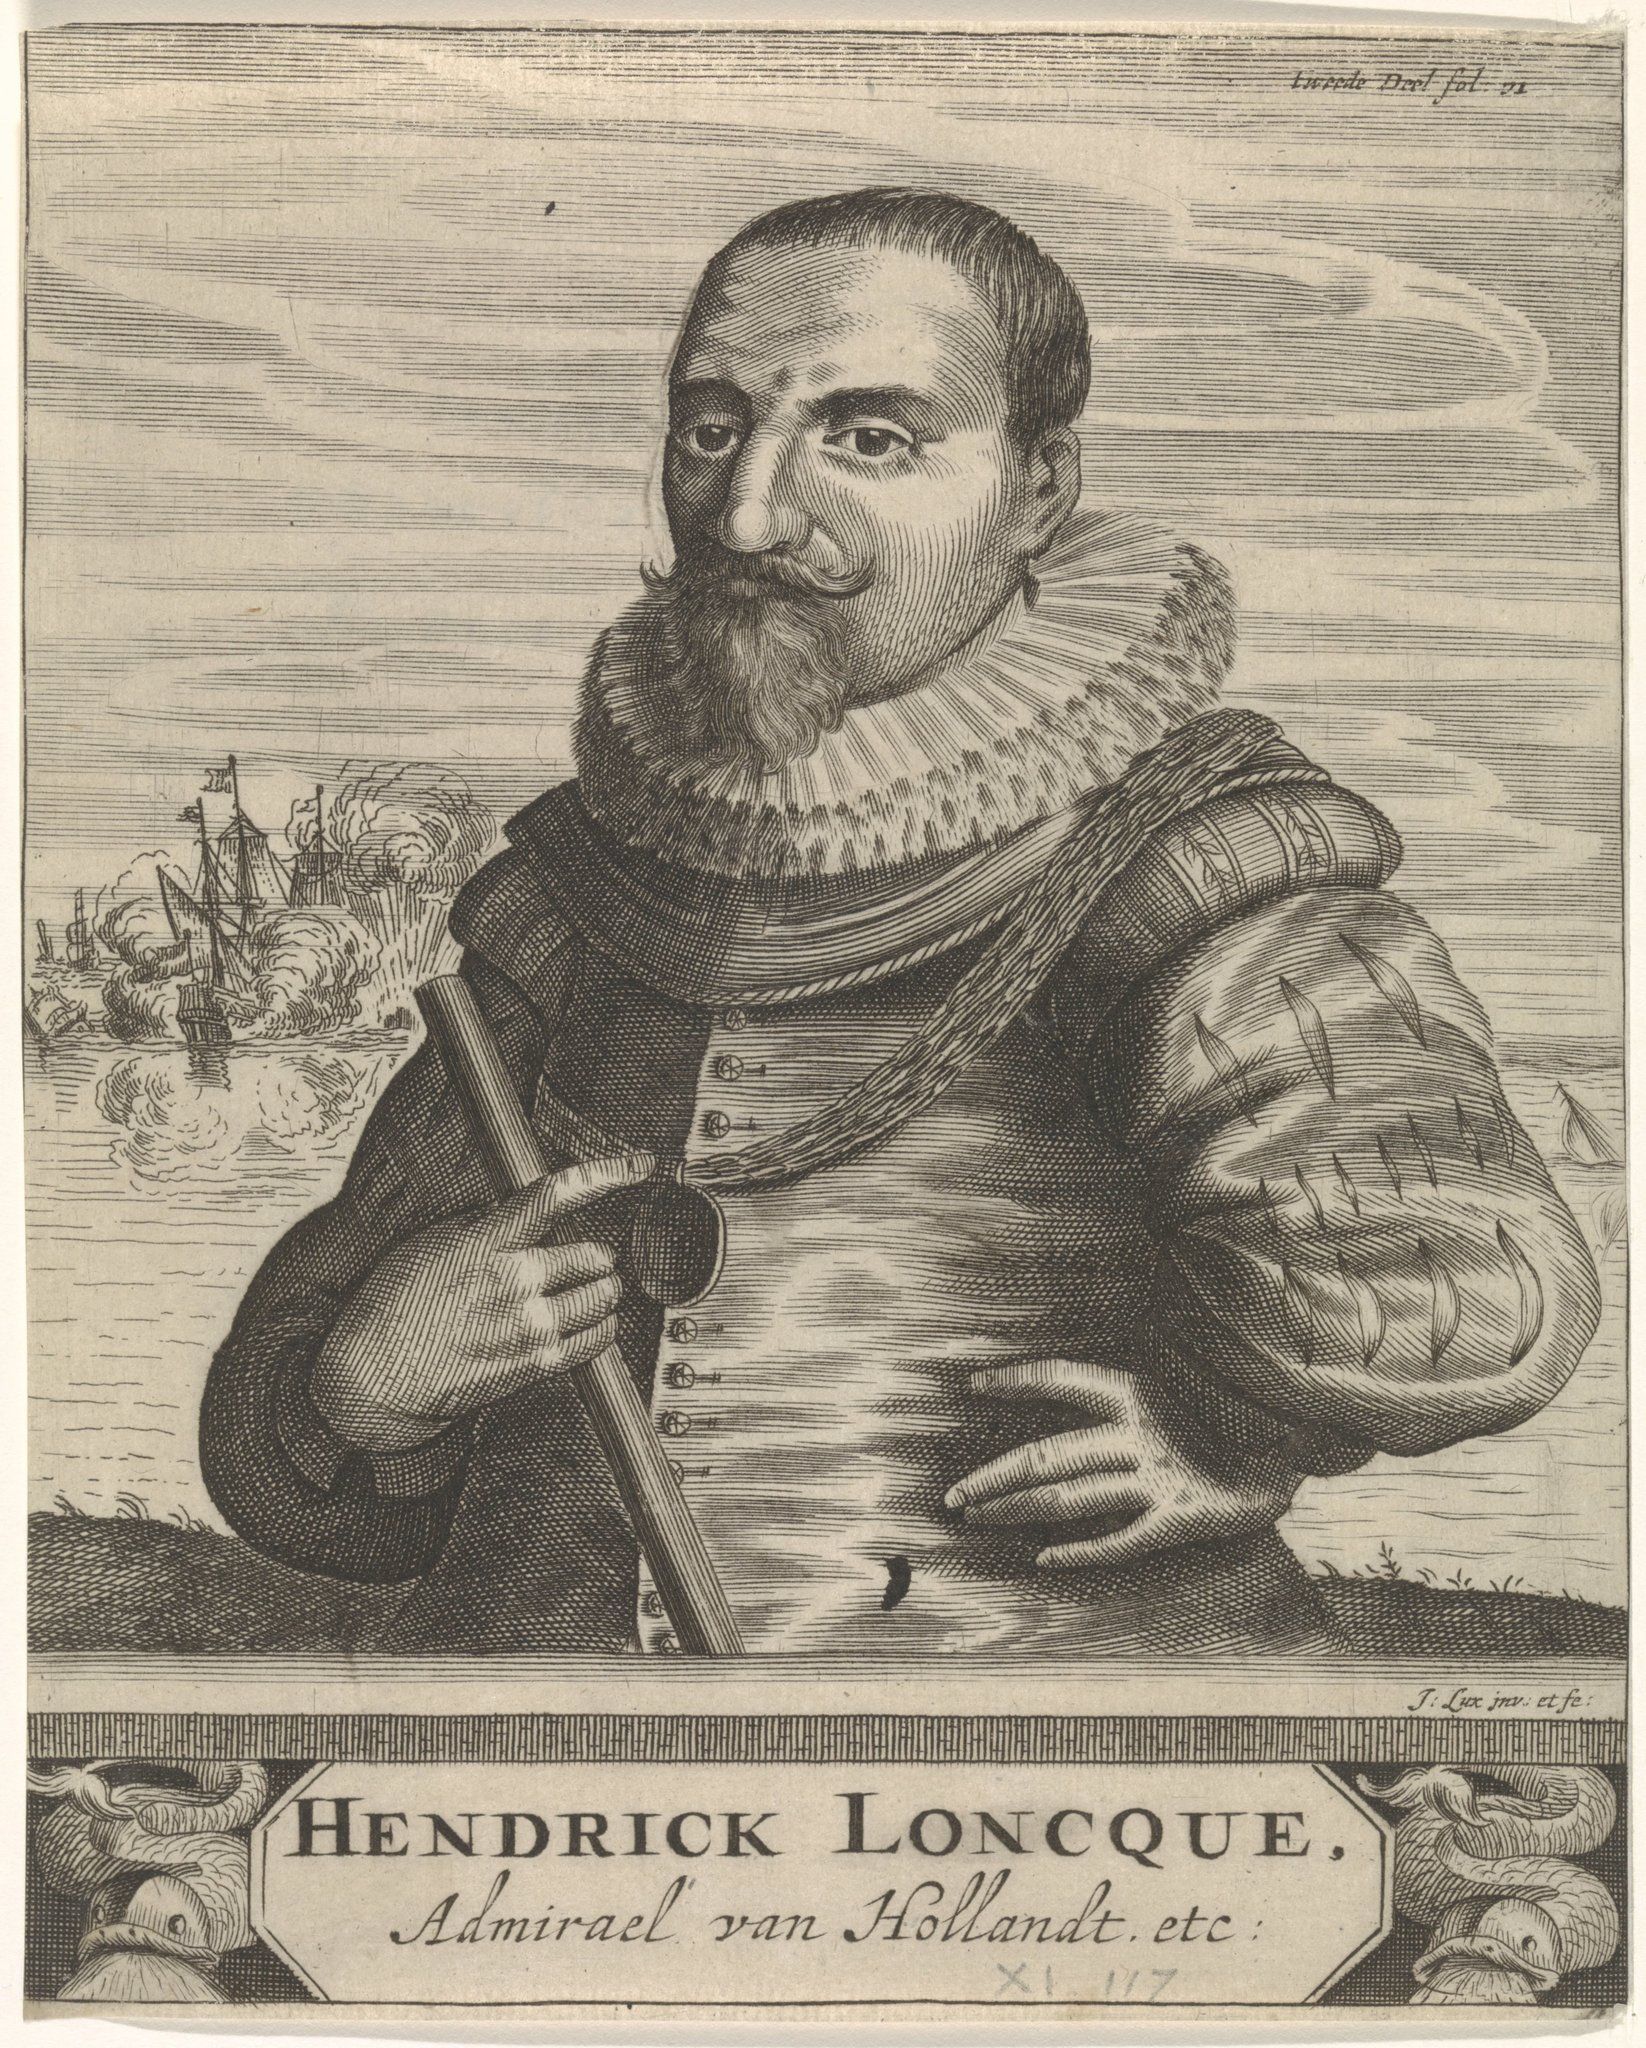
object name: print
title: Portret van Hendrick Cornelisz. Loncq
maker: ignatius lux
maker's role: draughtsman, print maker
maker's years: 1649-1713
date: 1676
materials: paper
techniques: engraving, etching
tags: hendrick cornelisz. loncq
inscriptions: collector's mark: Lugt 2228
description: Prent waarschijnlijk uit: Bos, Lambert van den. Leeven en daden der doorluchtighste zee-helden en ontdeckers van Landen (...). Amsterdam: Jan Claesz. ten Hoorn en Jan Bouman, 1676. Latere staat gebruikt in editie uit 1683.